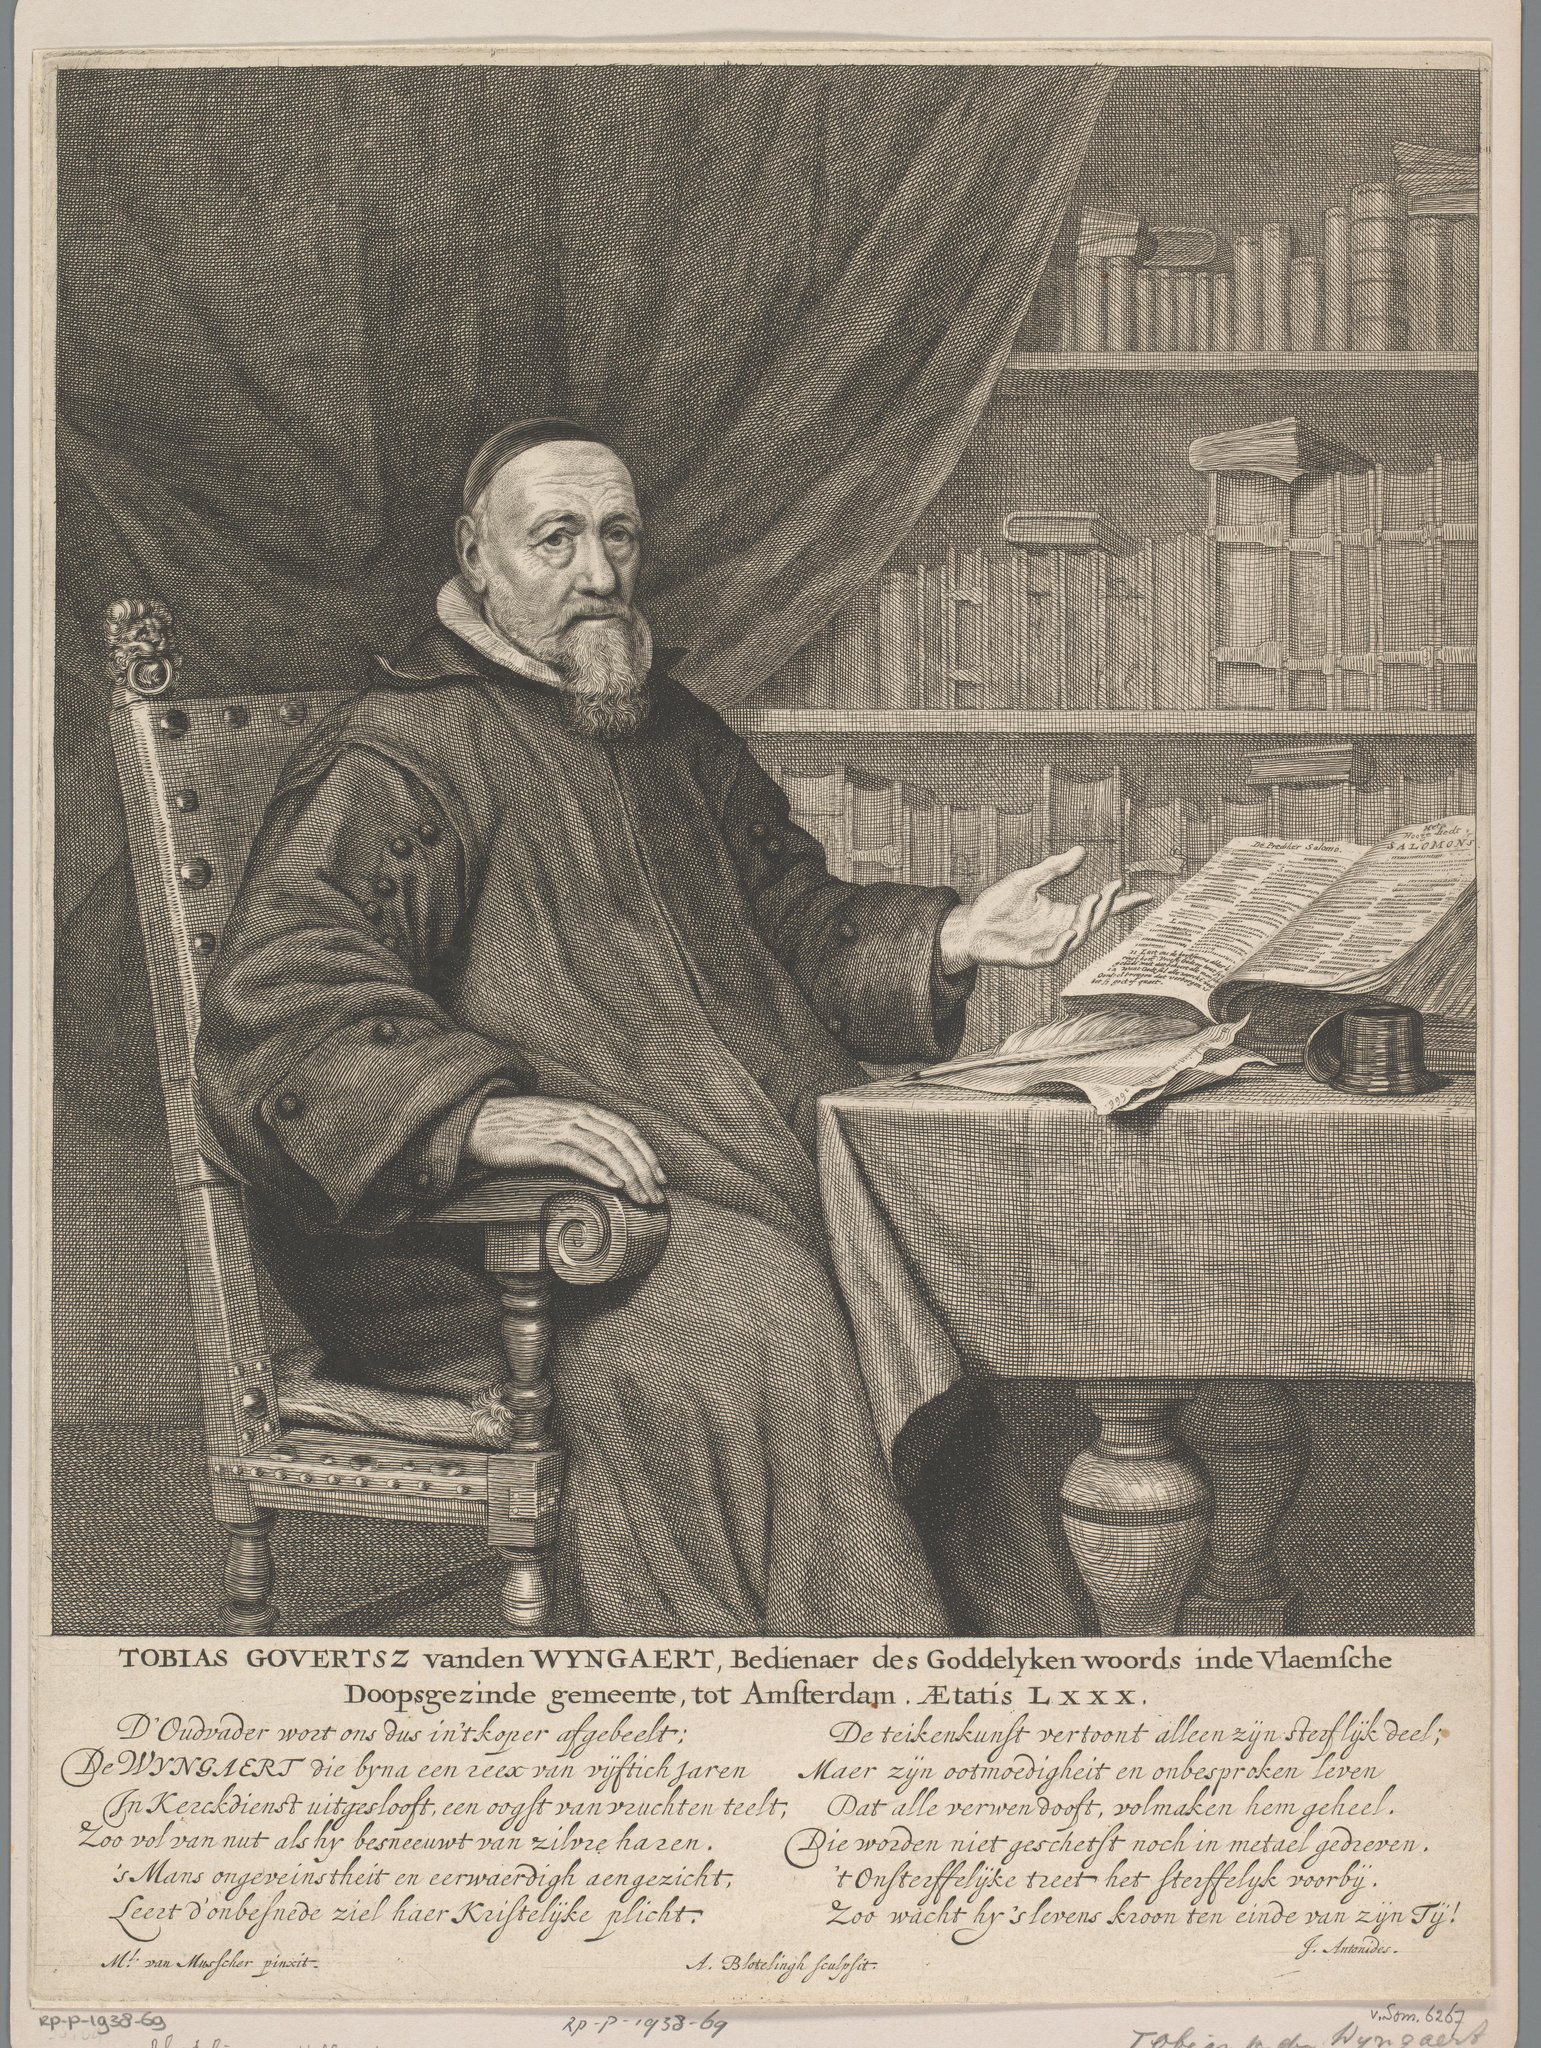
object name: print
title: Portret van Tobias Govertsz. van den Wyngaert op 80-jarige leeftijd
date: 1667-1684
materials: paper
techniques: engraving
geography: northern netherlands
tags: amsterdam, tobias govertsz. van den wyngaert, scholar in his study, historical persons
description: Met twaalfregelig onderschrift in het Nederlands.